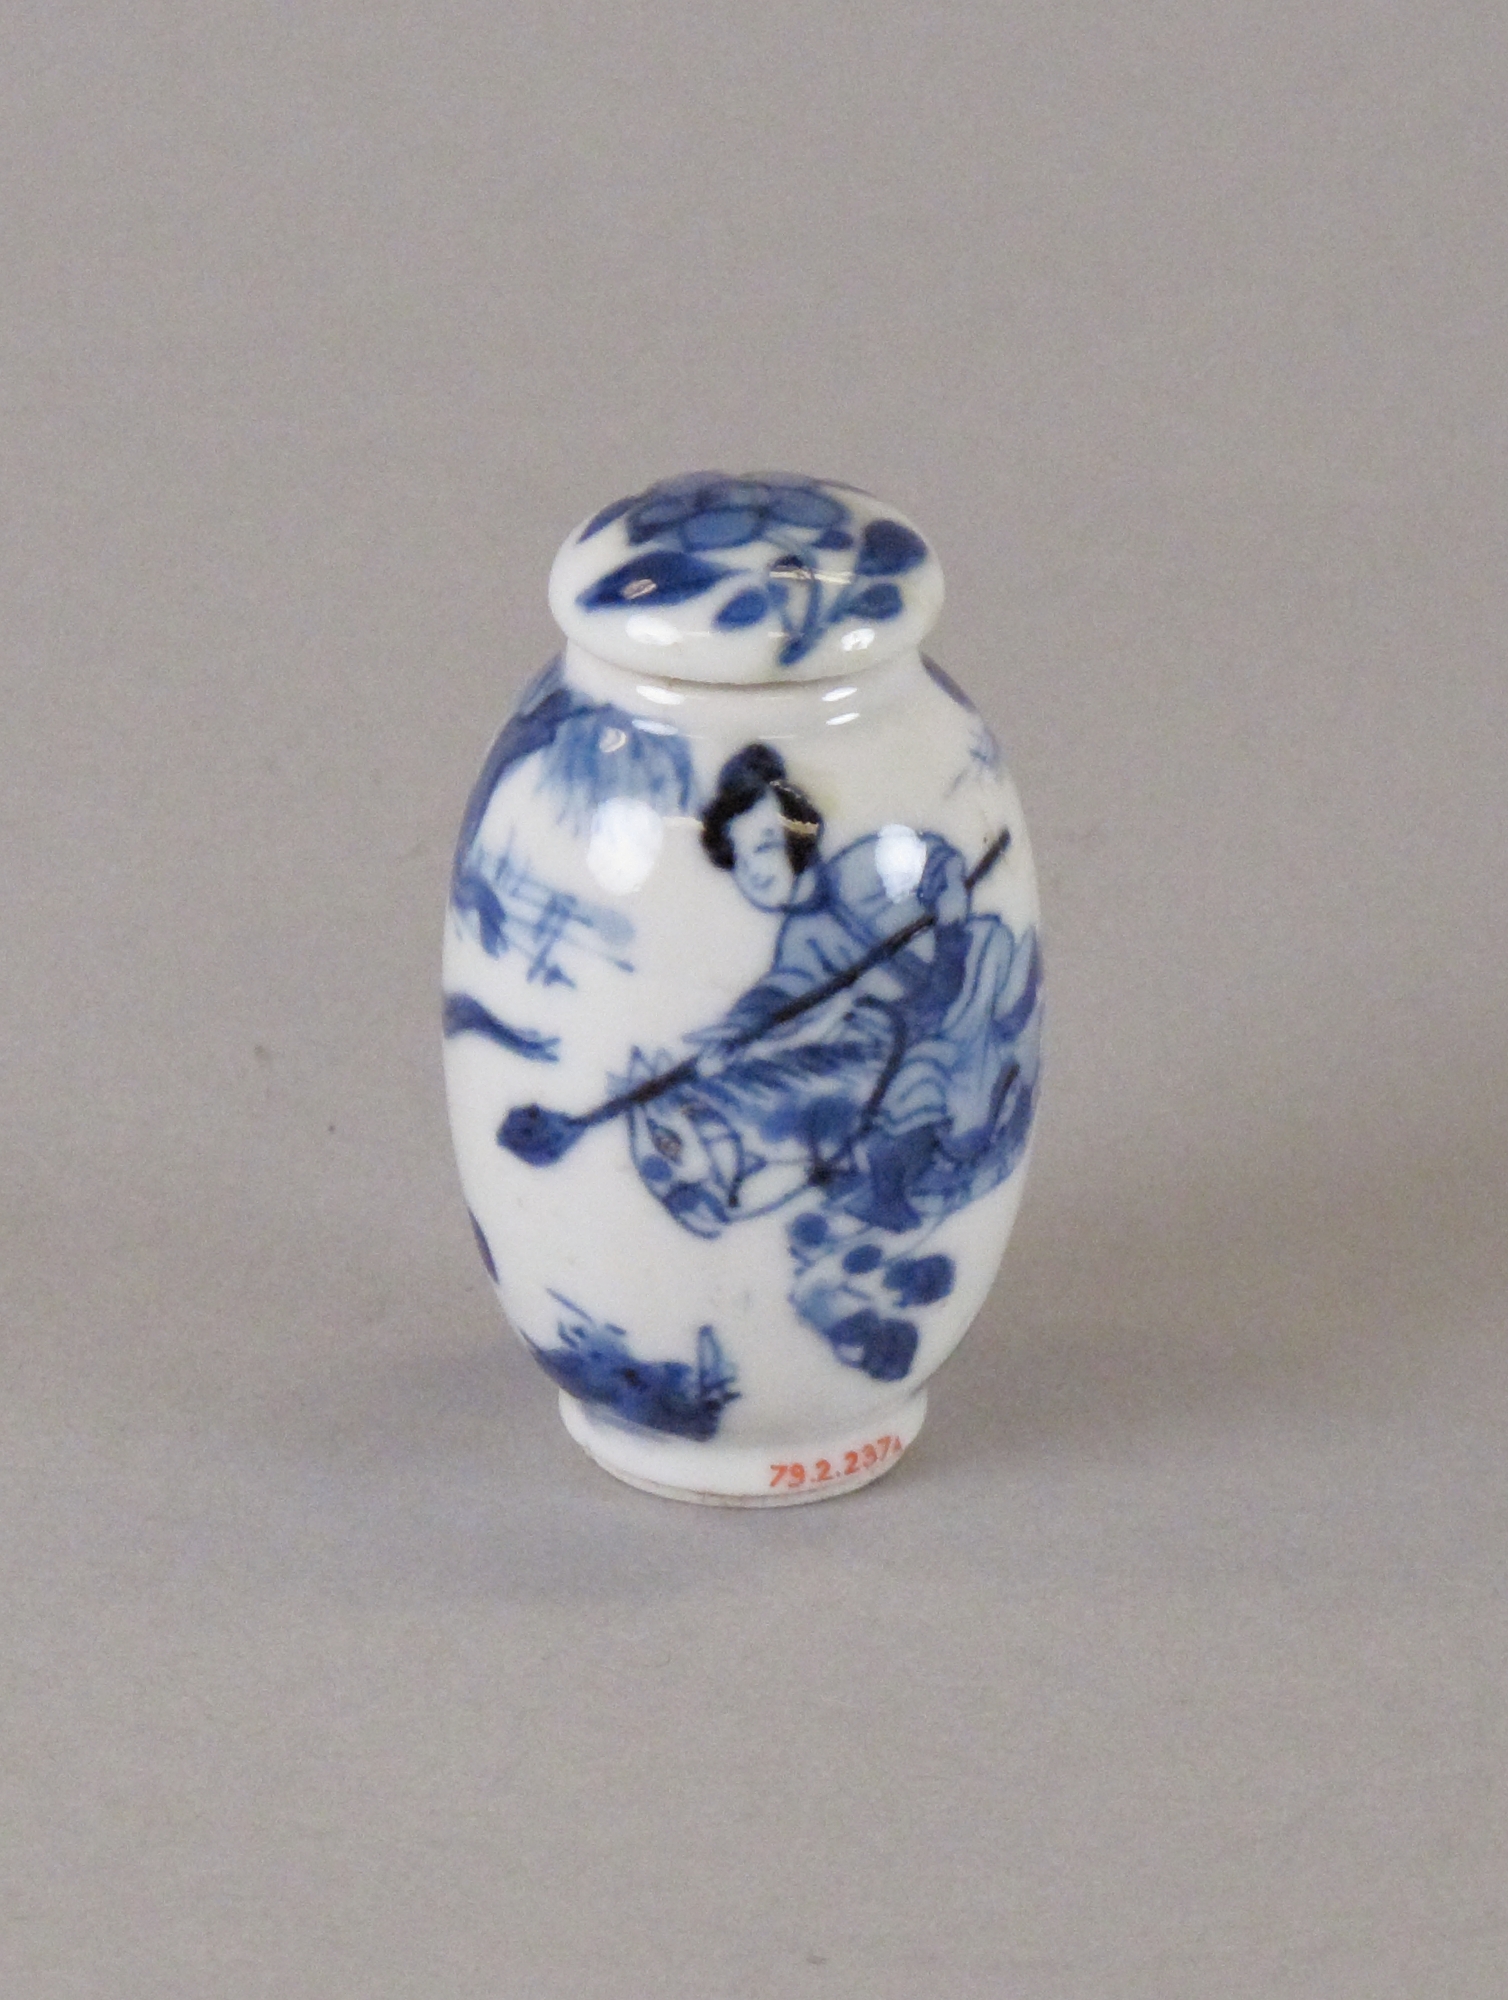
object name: covered jar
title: Jar with Female Rider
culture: chinese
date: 1634-1666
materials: cobalt, glaze, porcelain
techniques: painting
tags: women,horses,flowers